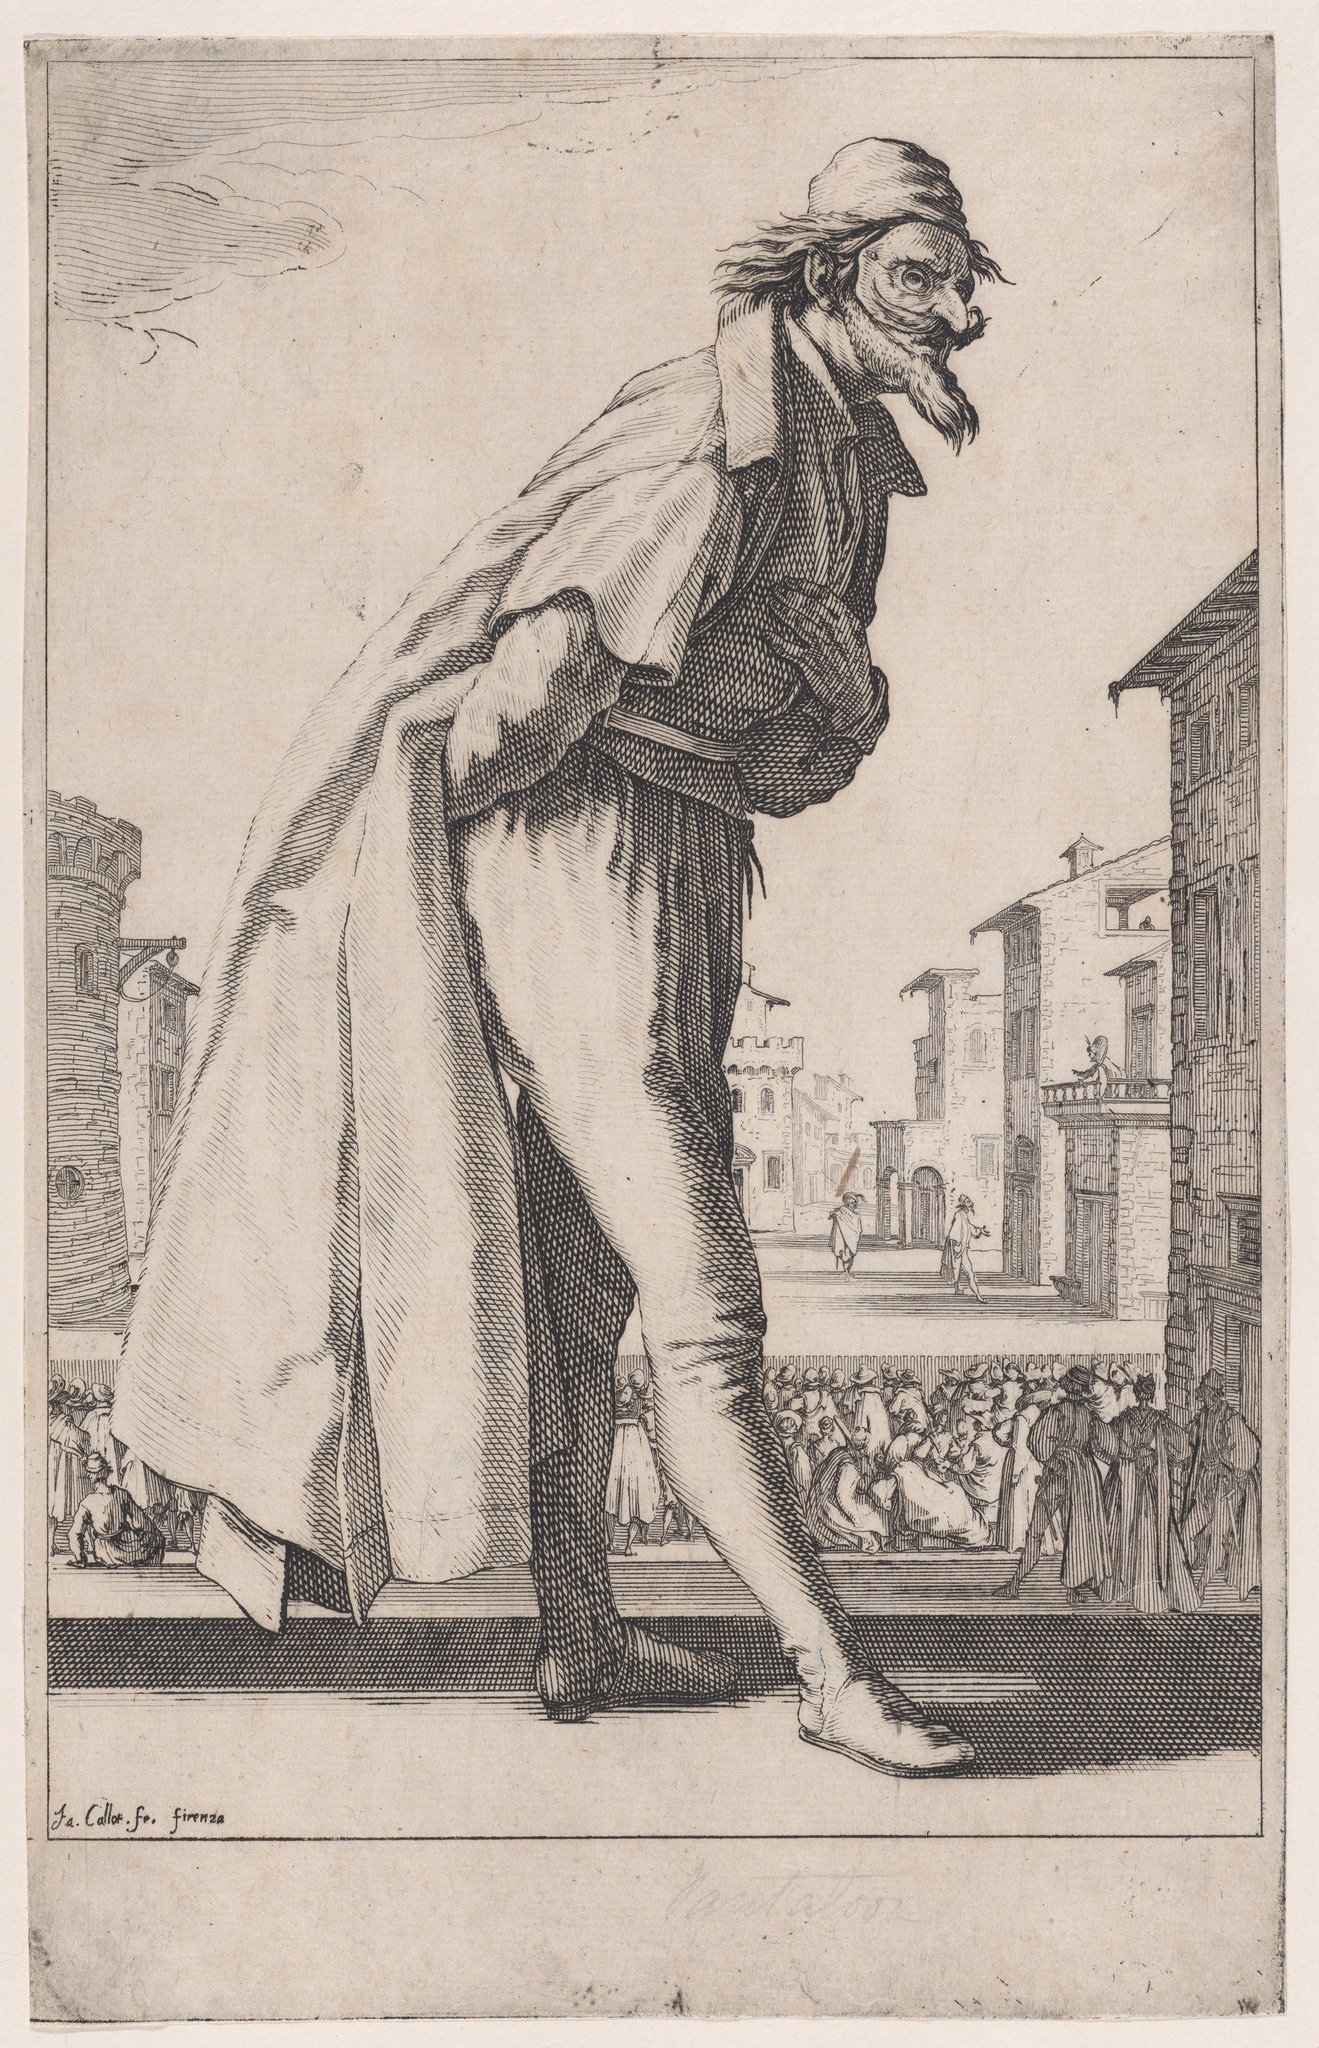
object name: print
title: Le Pantalon ou Cassandre, from "Les Trois Pantalons pièces appélees Les Trois Acteurs" (The Three Pants also called the Three Actors)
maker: jacques callot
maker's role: artist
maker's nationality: french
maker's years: 1592-1635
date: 1618-1620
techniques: engraving, etching